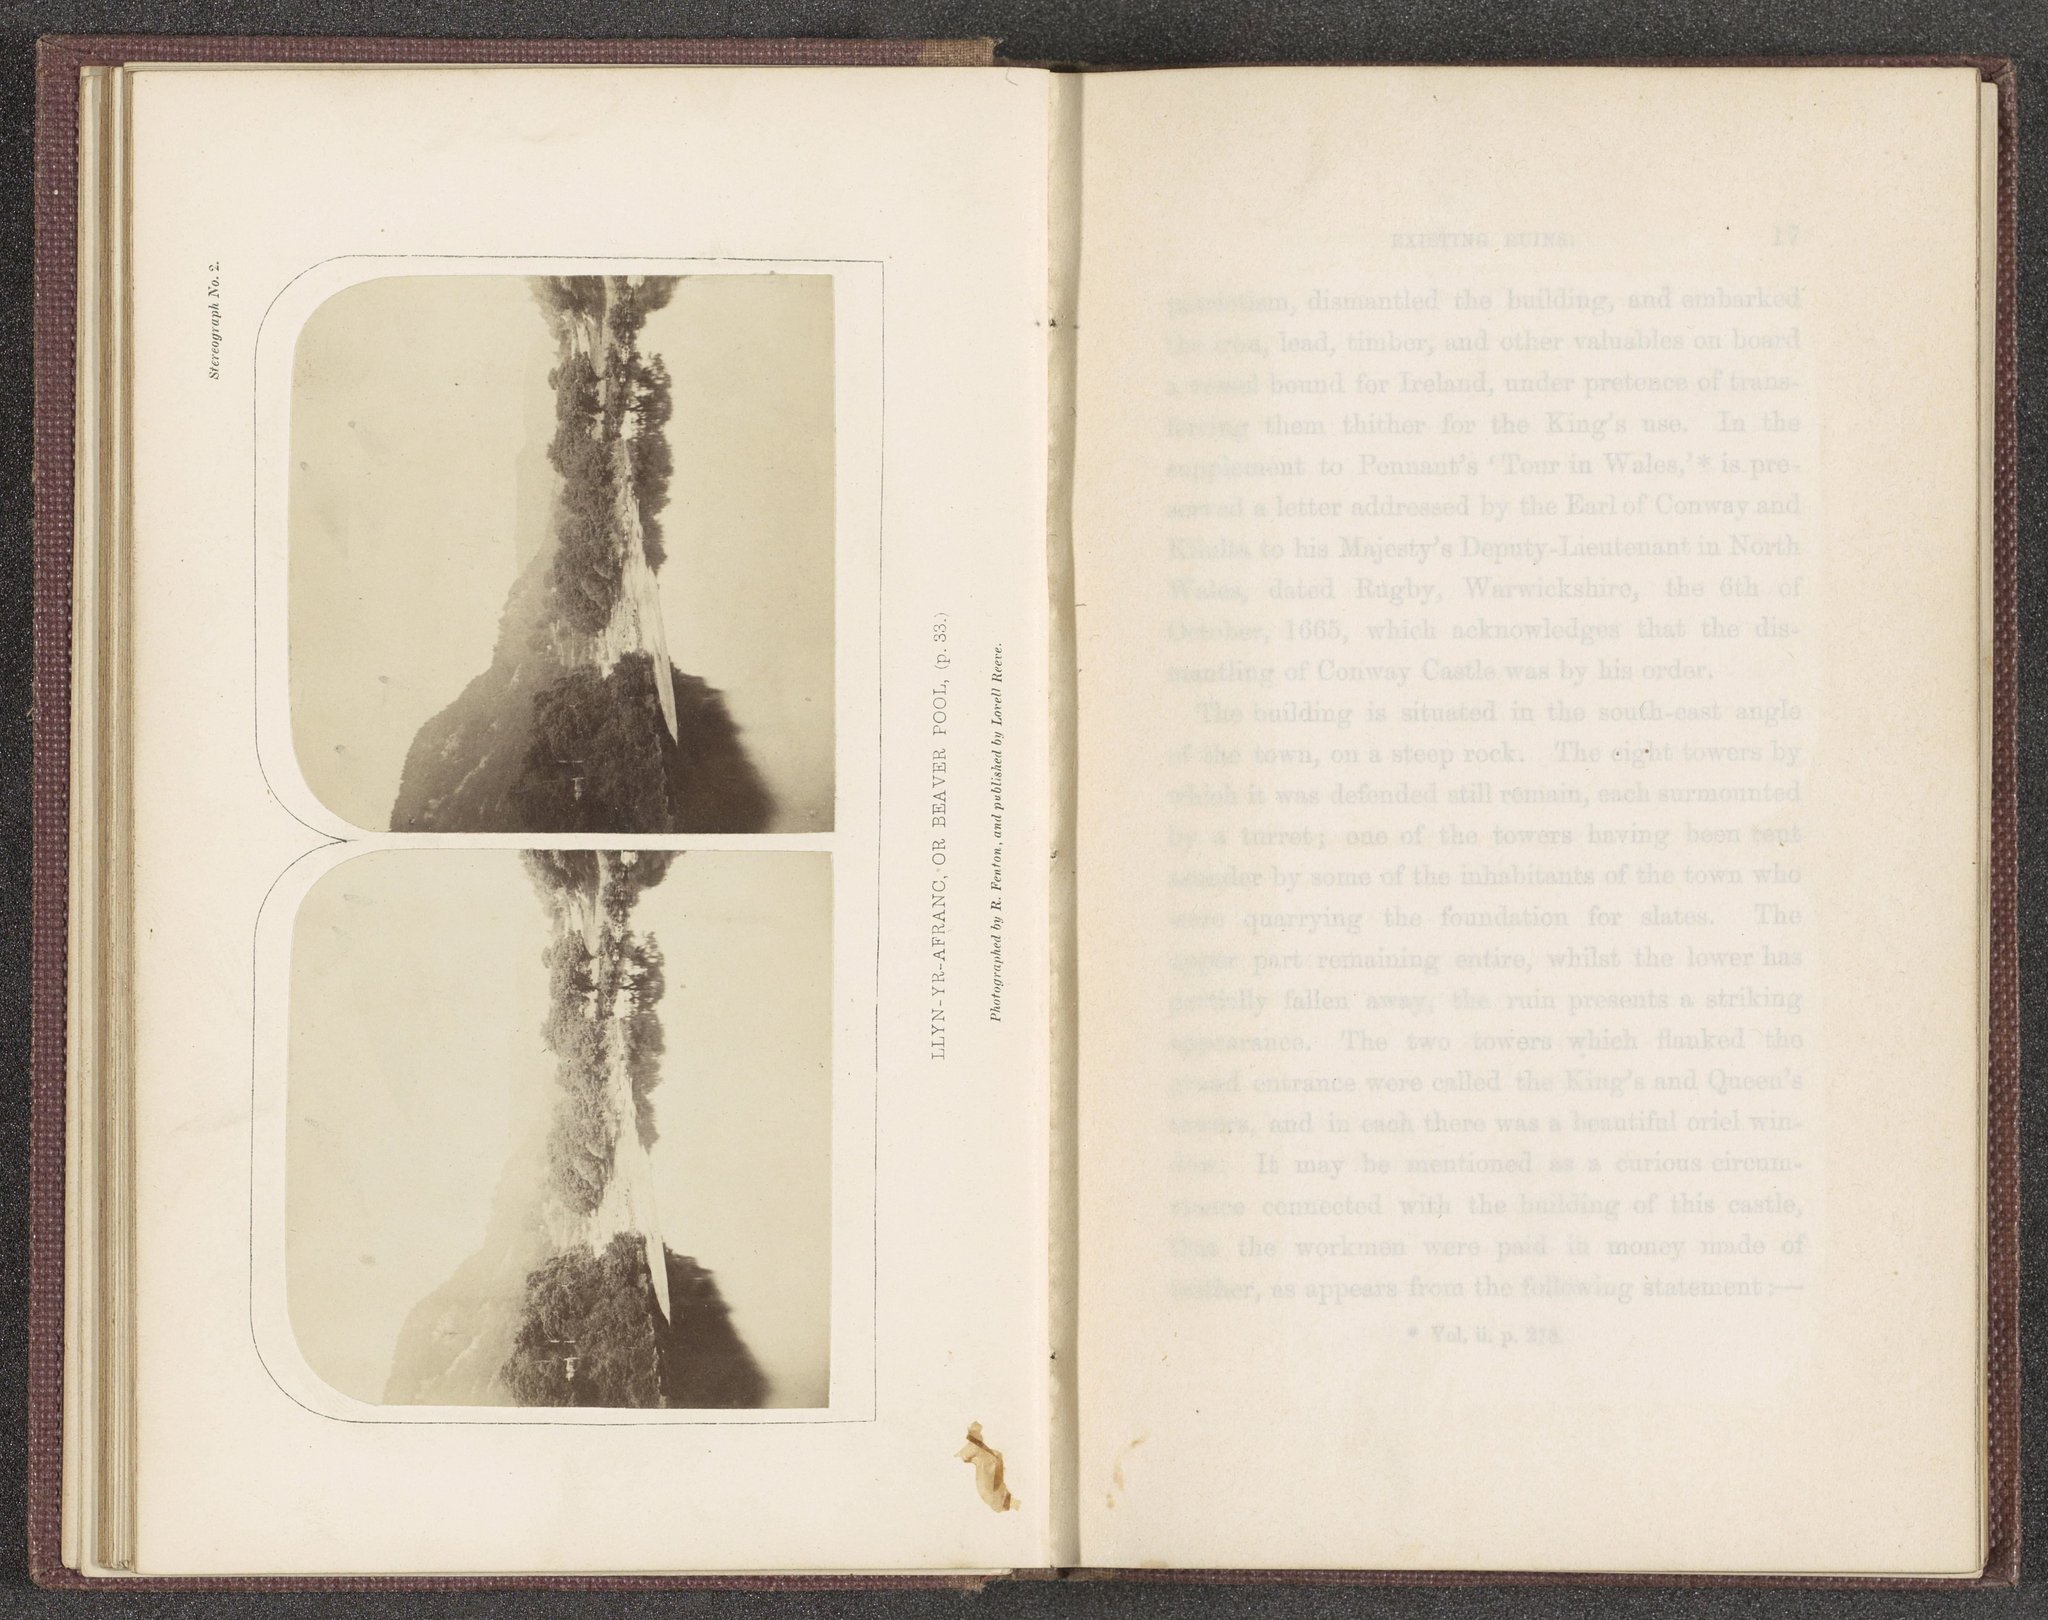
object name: page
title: Llyn-ar-afranc or Beaver Pool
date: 1859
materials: paper, photographic support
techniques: albumen print, printing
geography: wales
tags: lake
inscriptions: number: ‘Stereograph No. 2.’